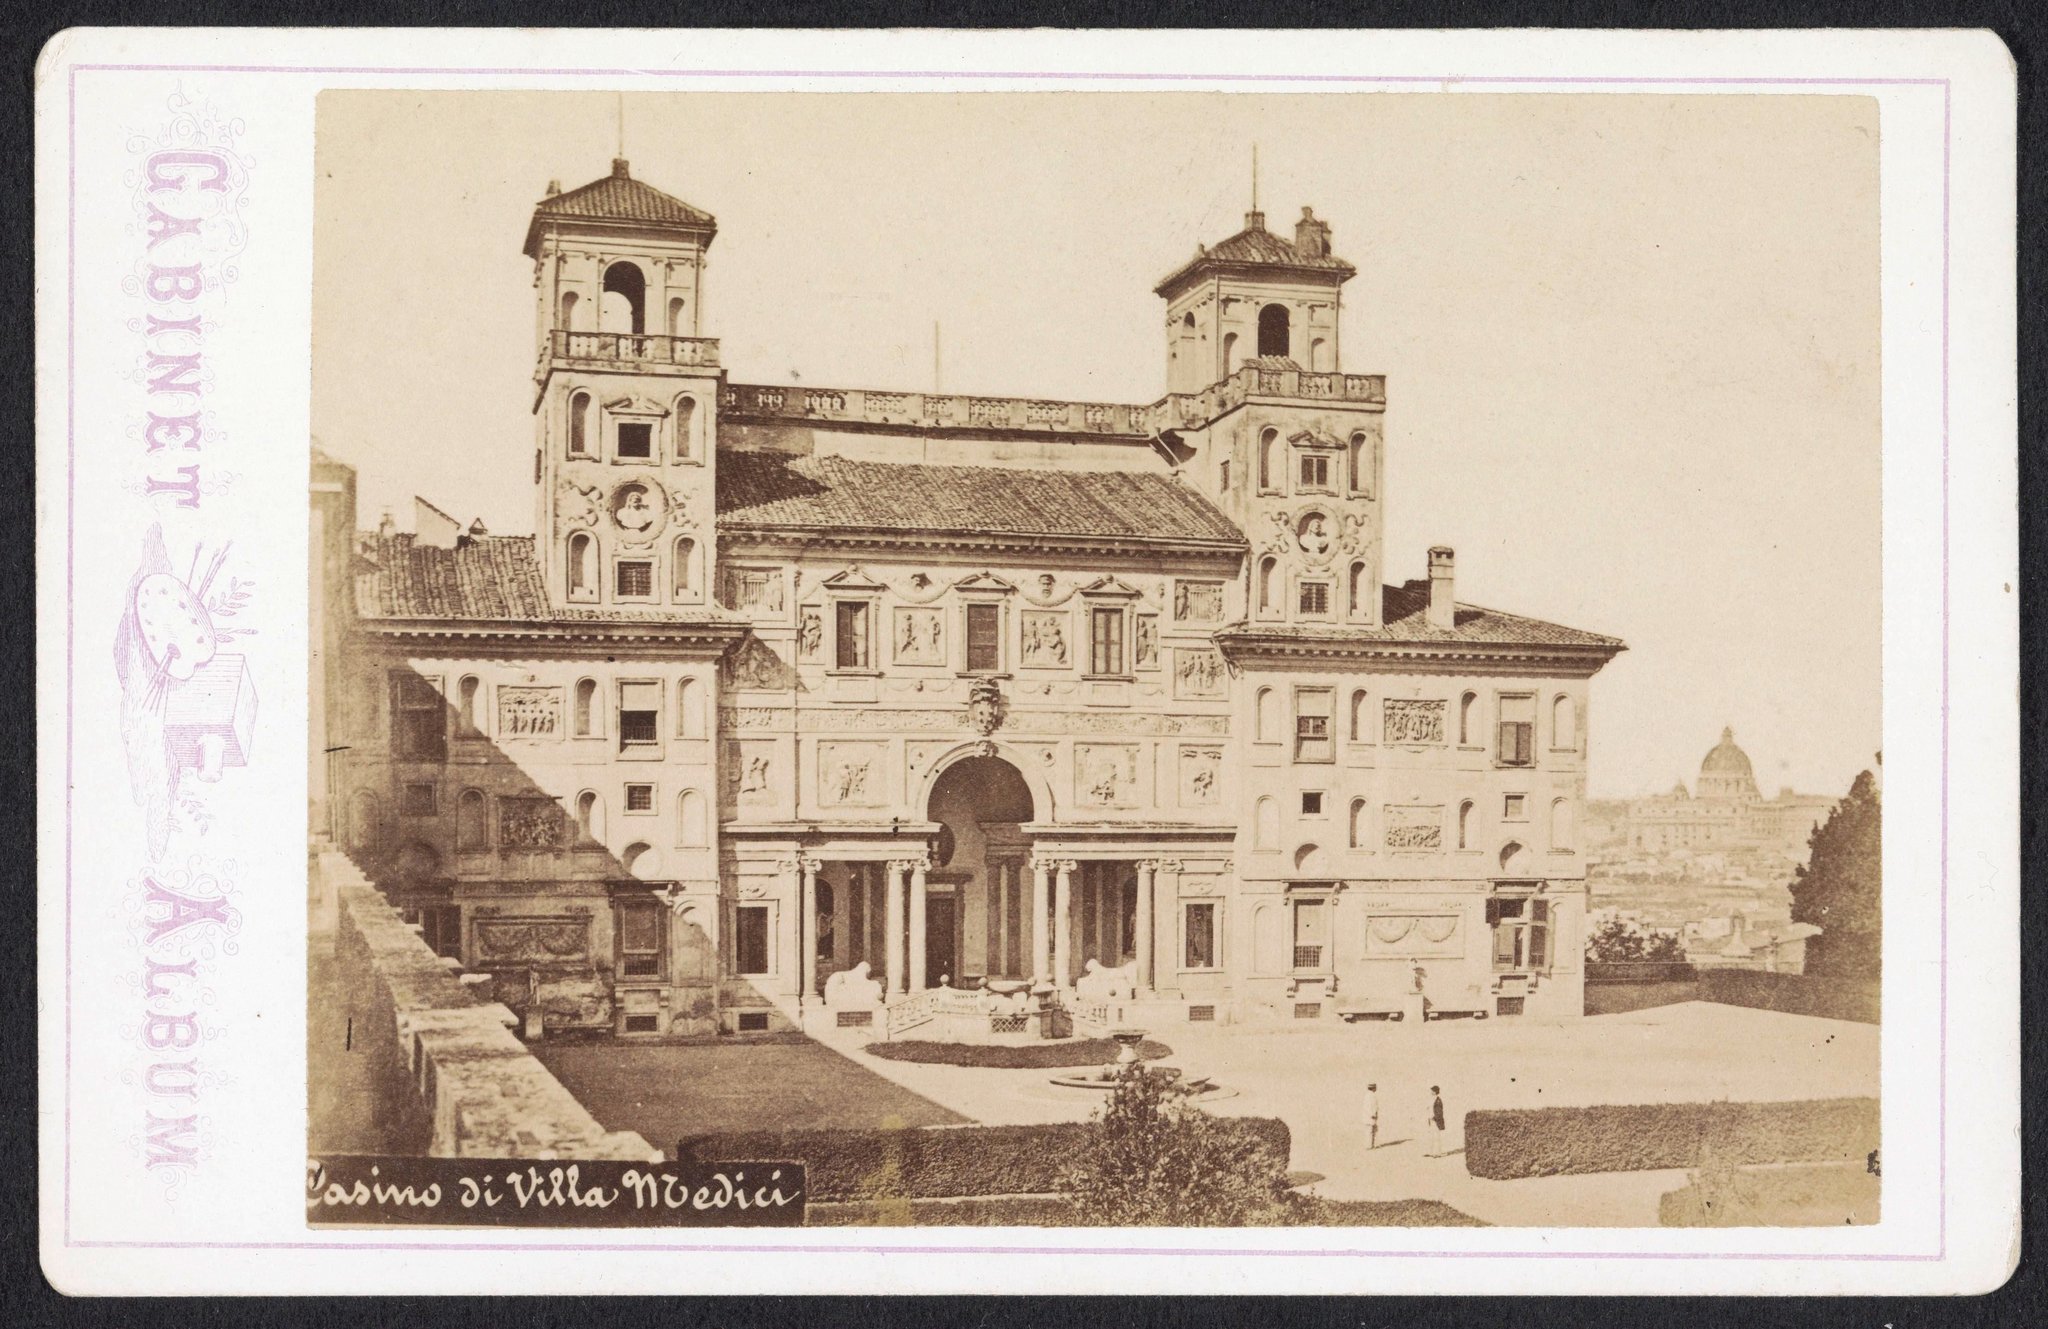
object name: cabinet photograph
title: Casino di Villa Medici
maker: Anonymous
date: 1850-1900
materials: cardboard, photographic support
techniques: albumen print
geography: villa medici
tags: villa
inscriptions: annotation: ‘Roma’, inscription: ‘Cabinet Album’